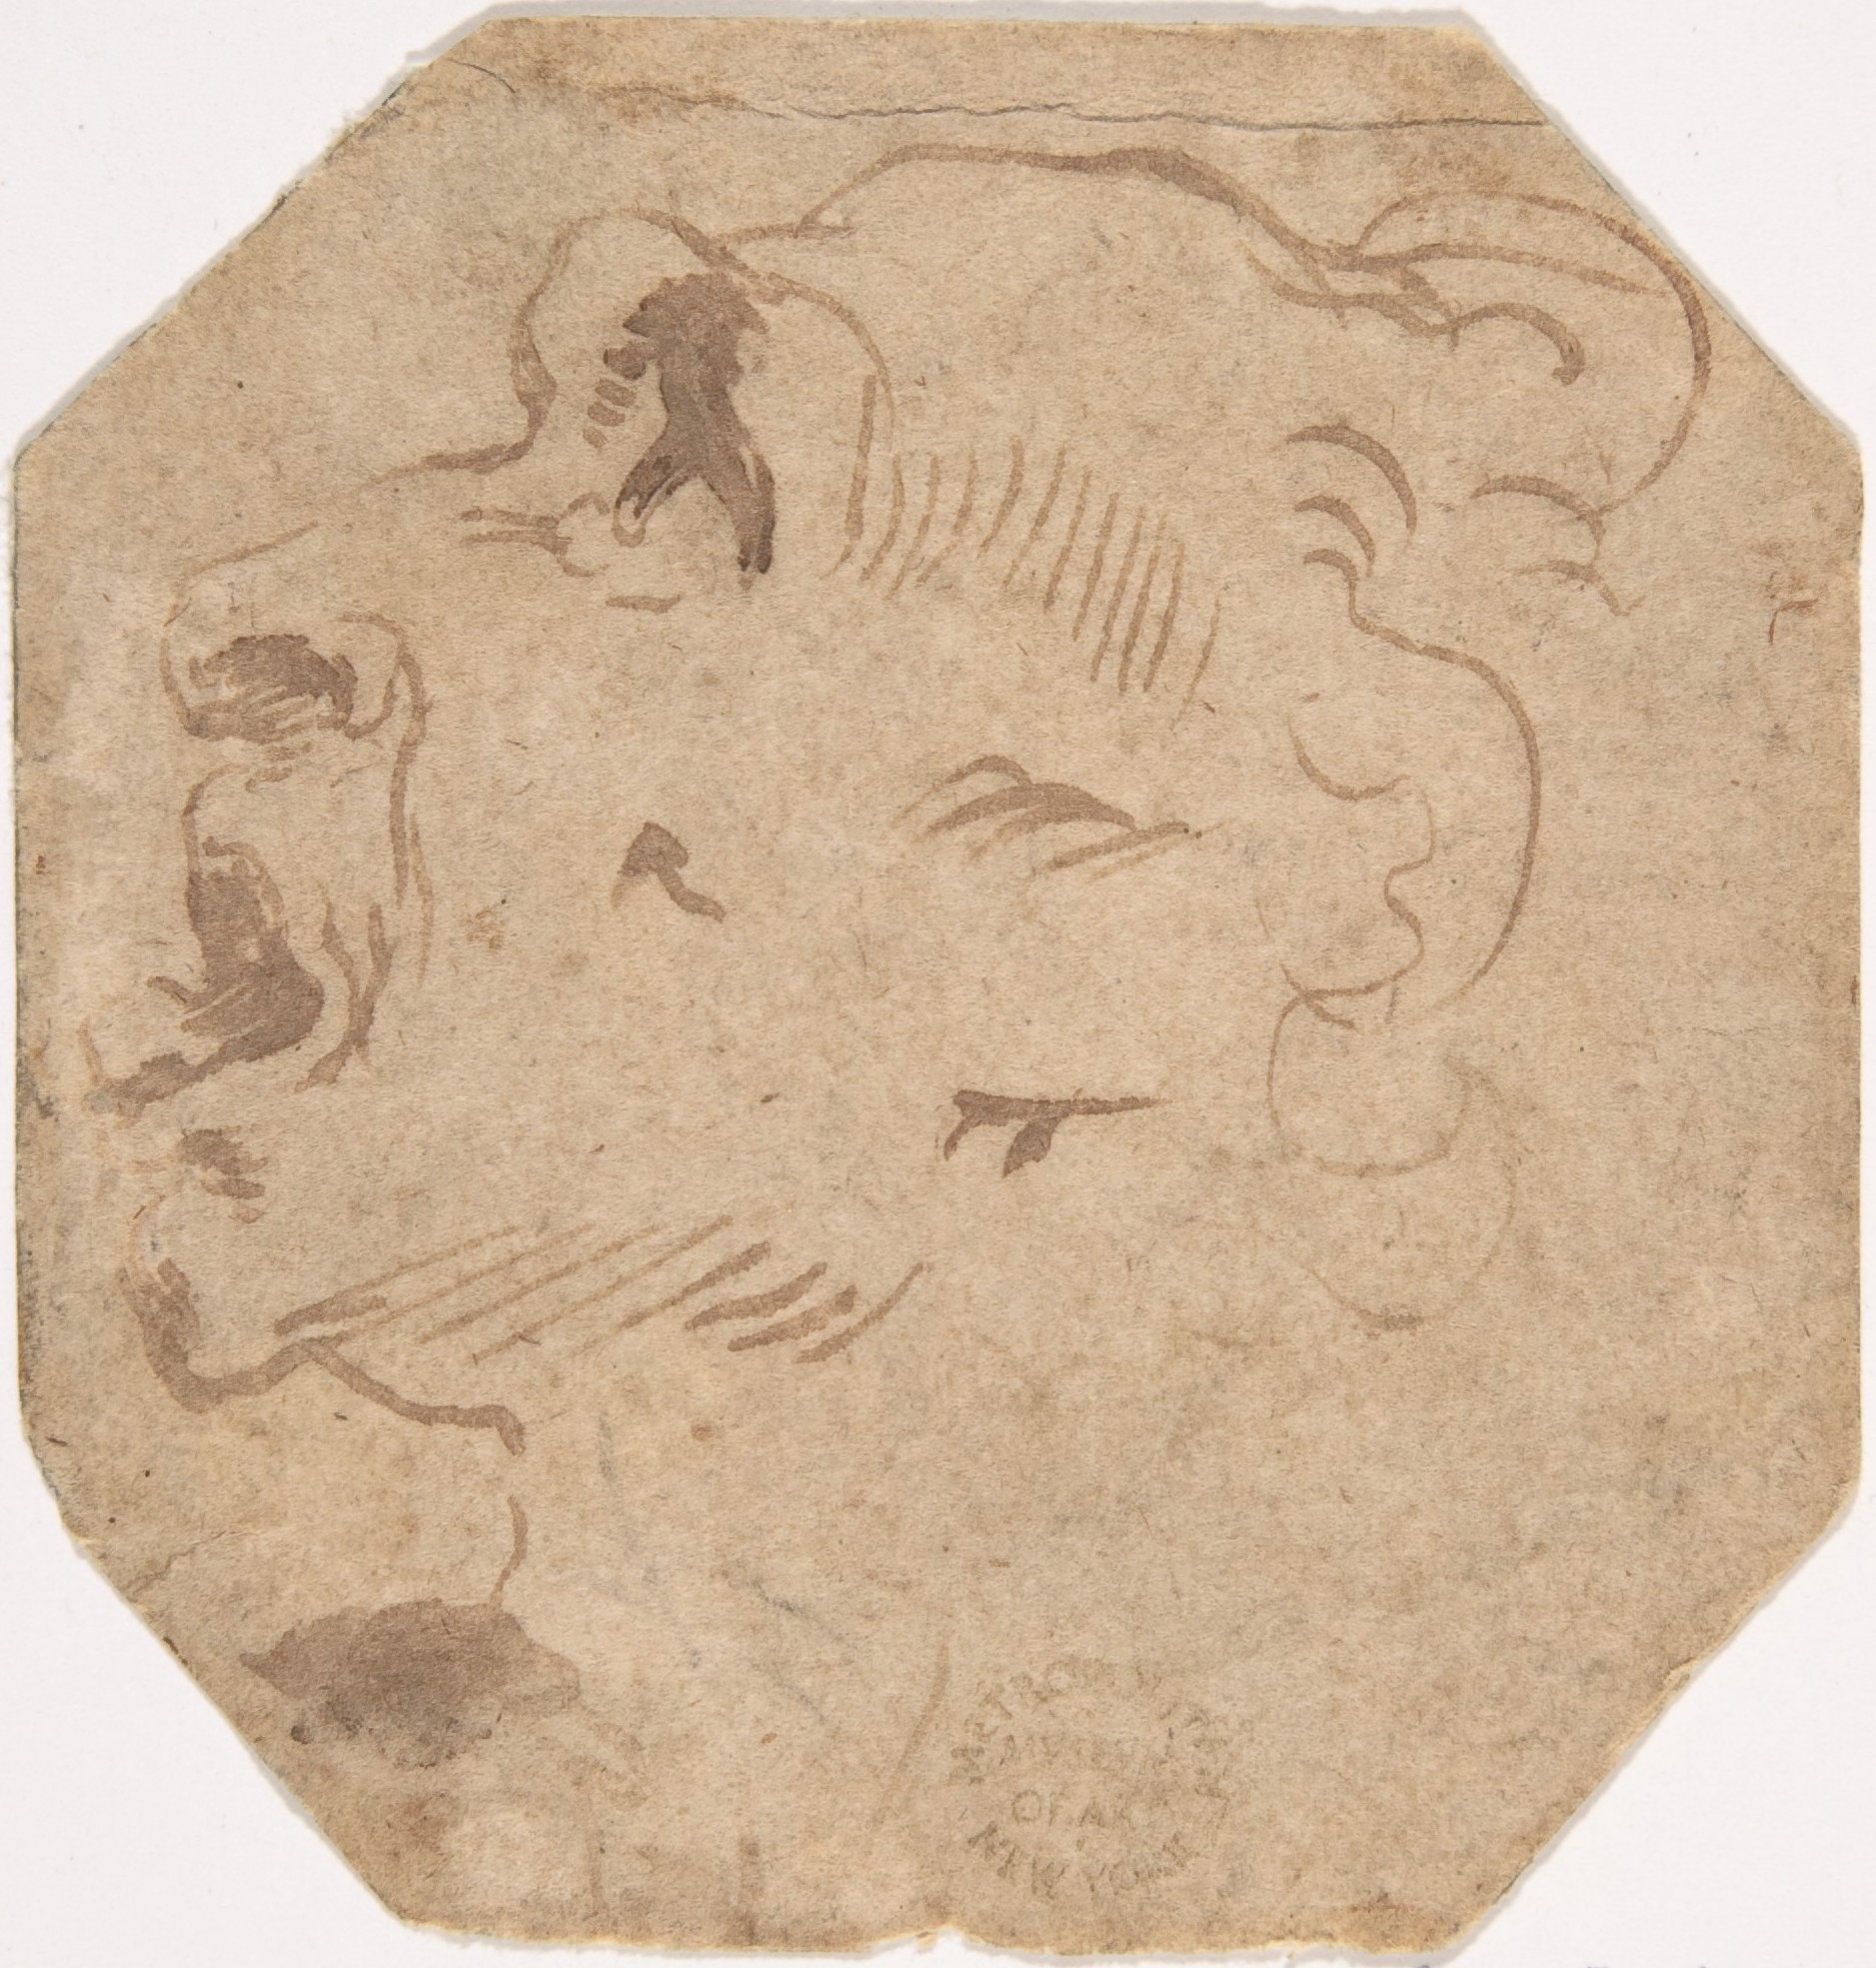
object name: drawing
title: Head of a Man in Profile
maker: anonymous, italian, 16th century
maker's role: artist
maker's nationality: italian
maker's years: 1550-1600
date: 1501-1600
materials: ink, paper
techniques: pen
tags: heads,men